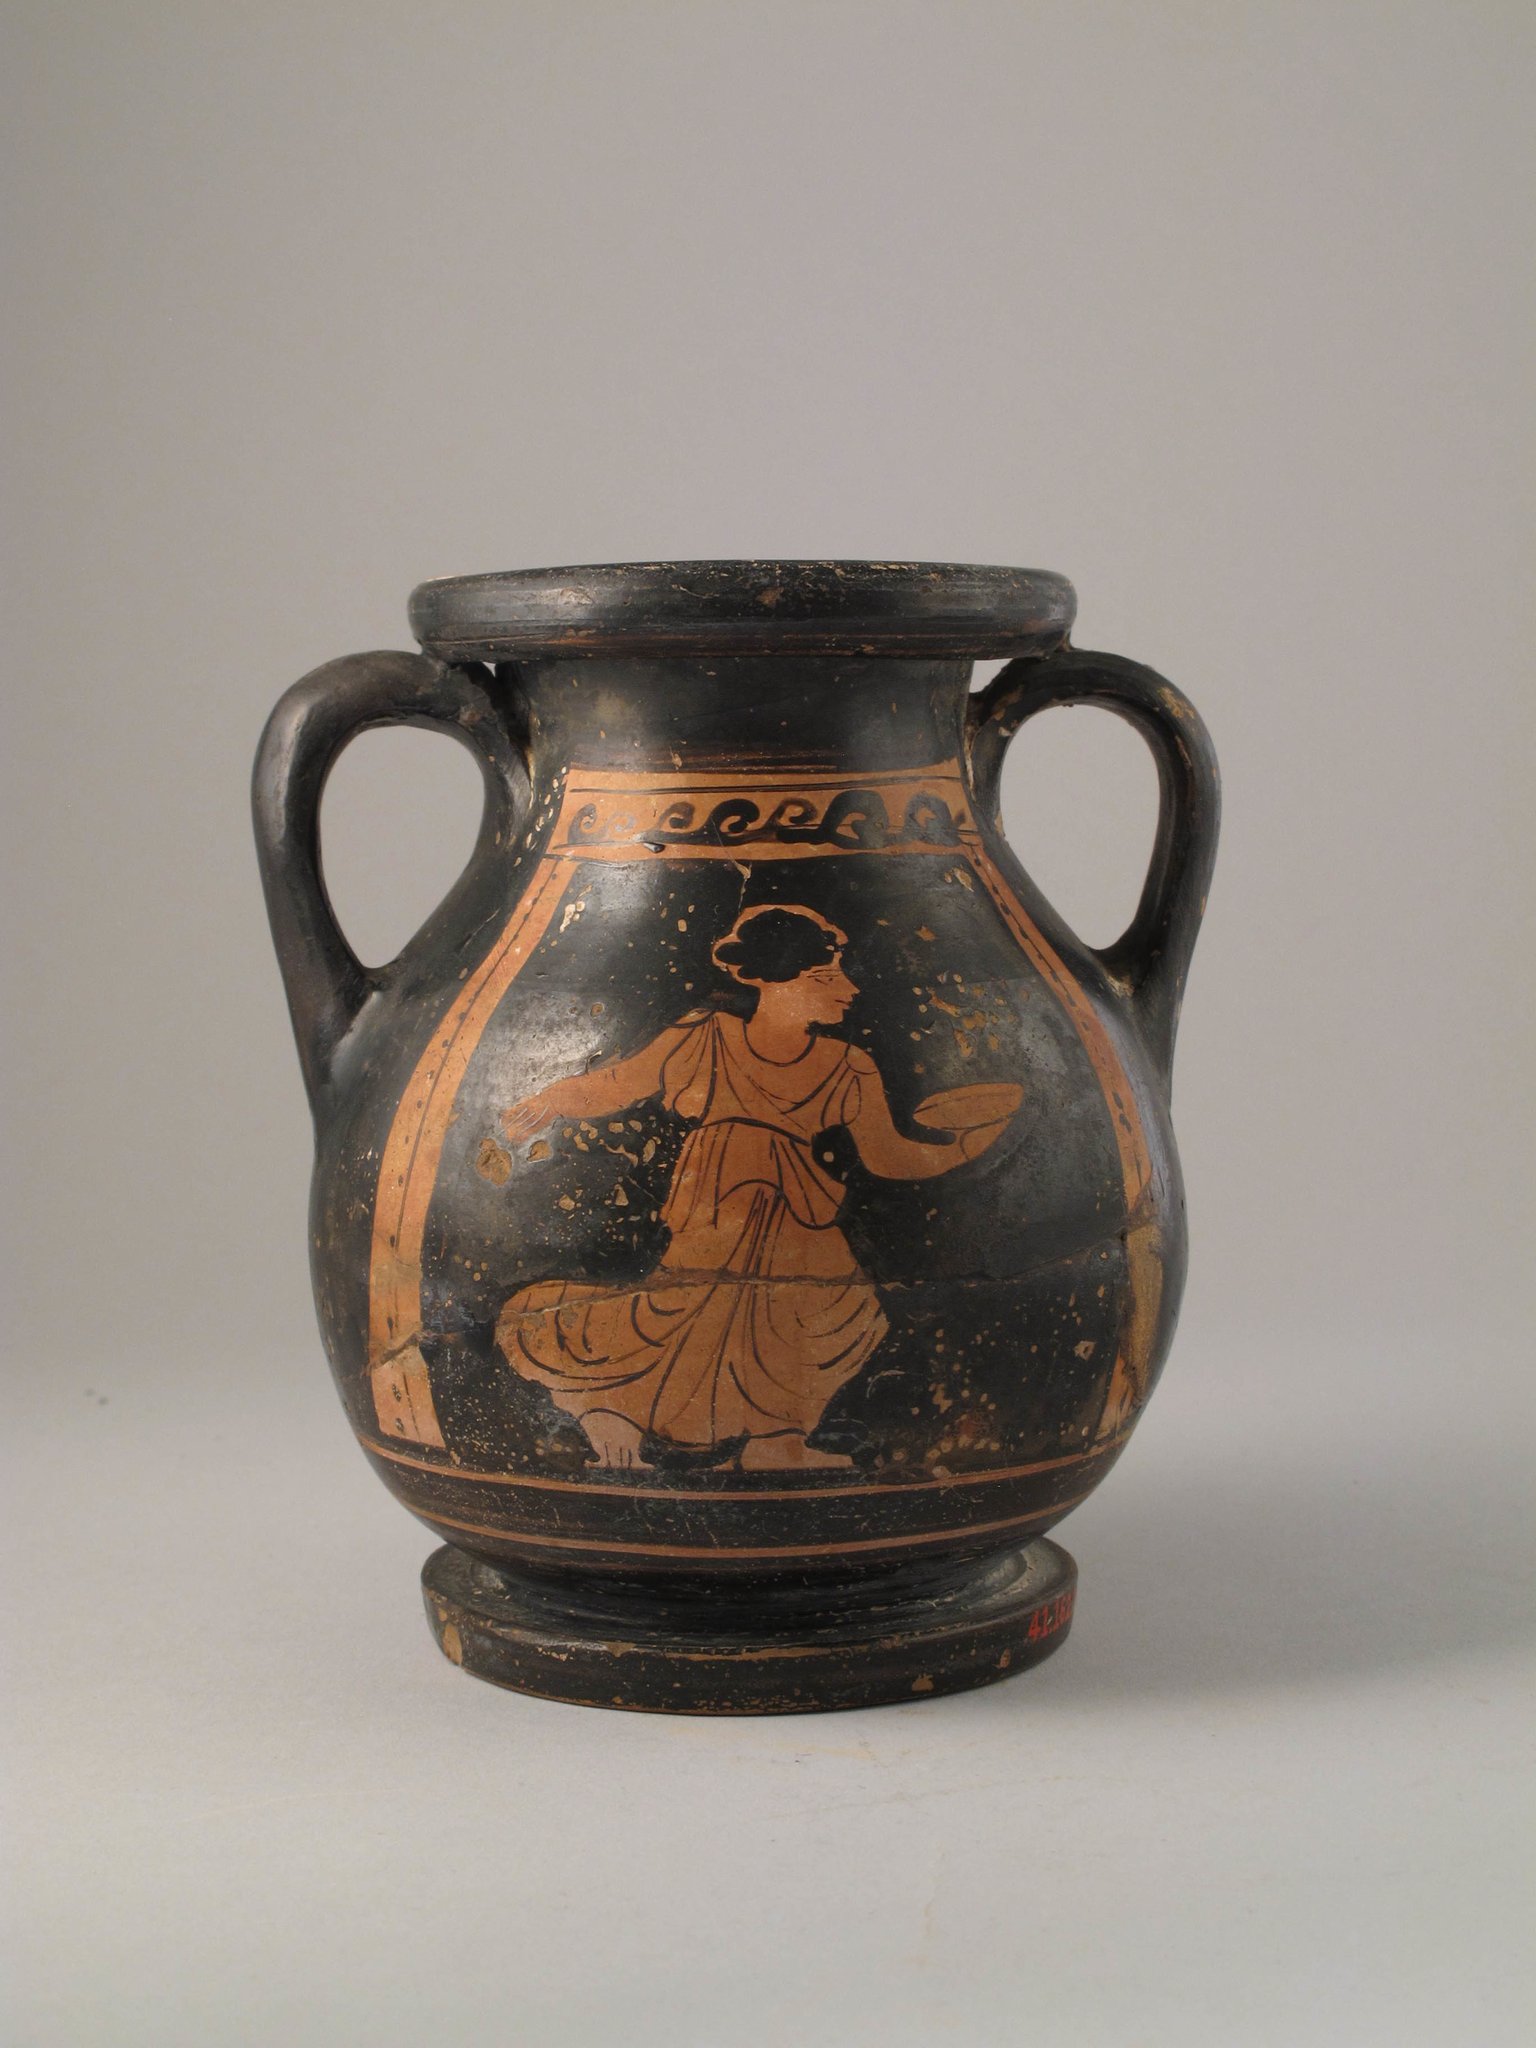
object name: pelike, miniature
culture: greek, boeotian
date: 434-401 BCE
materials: terracotta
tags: girls